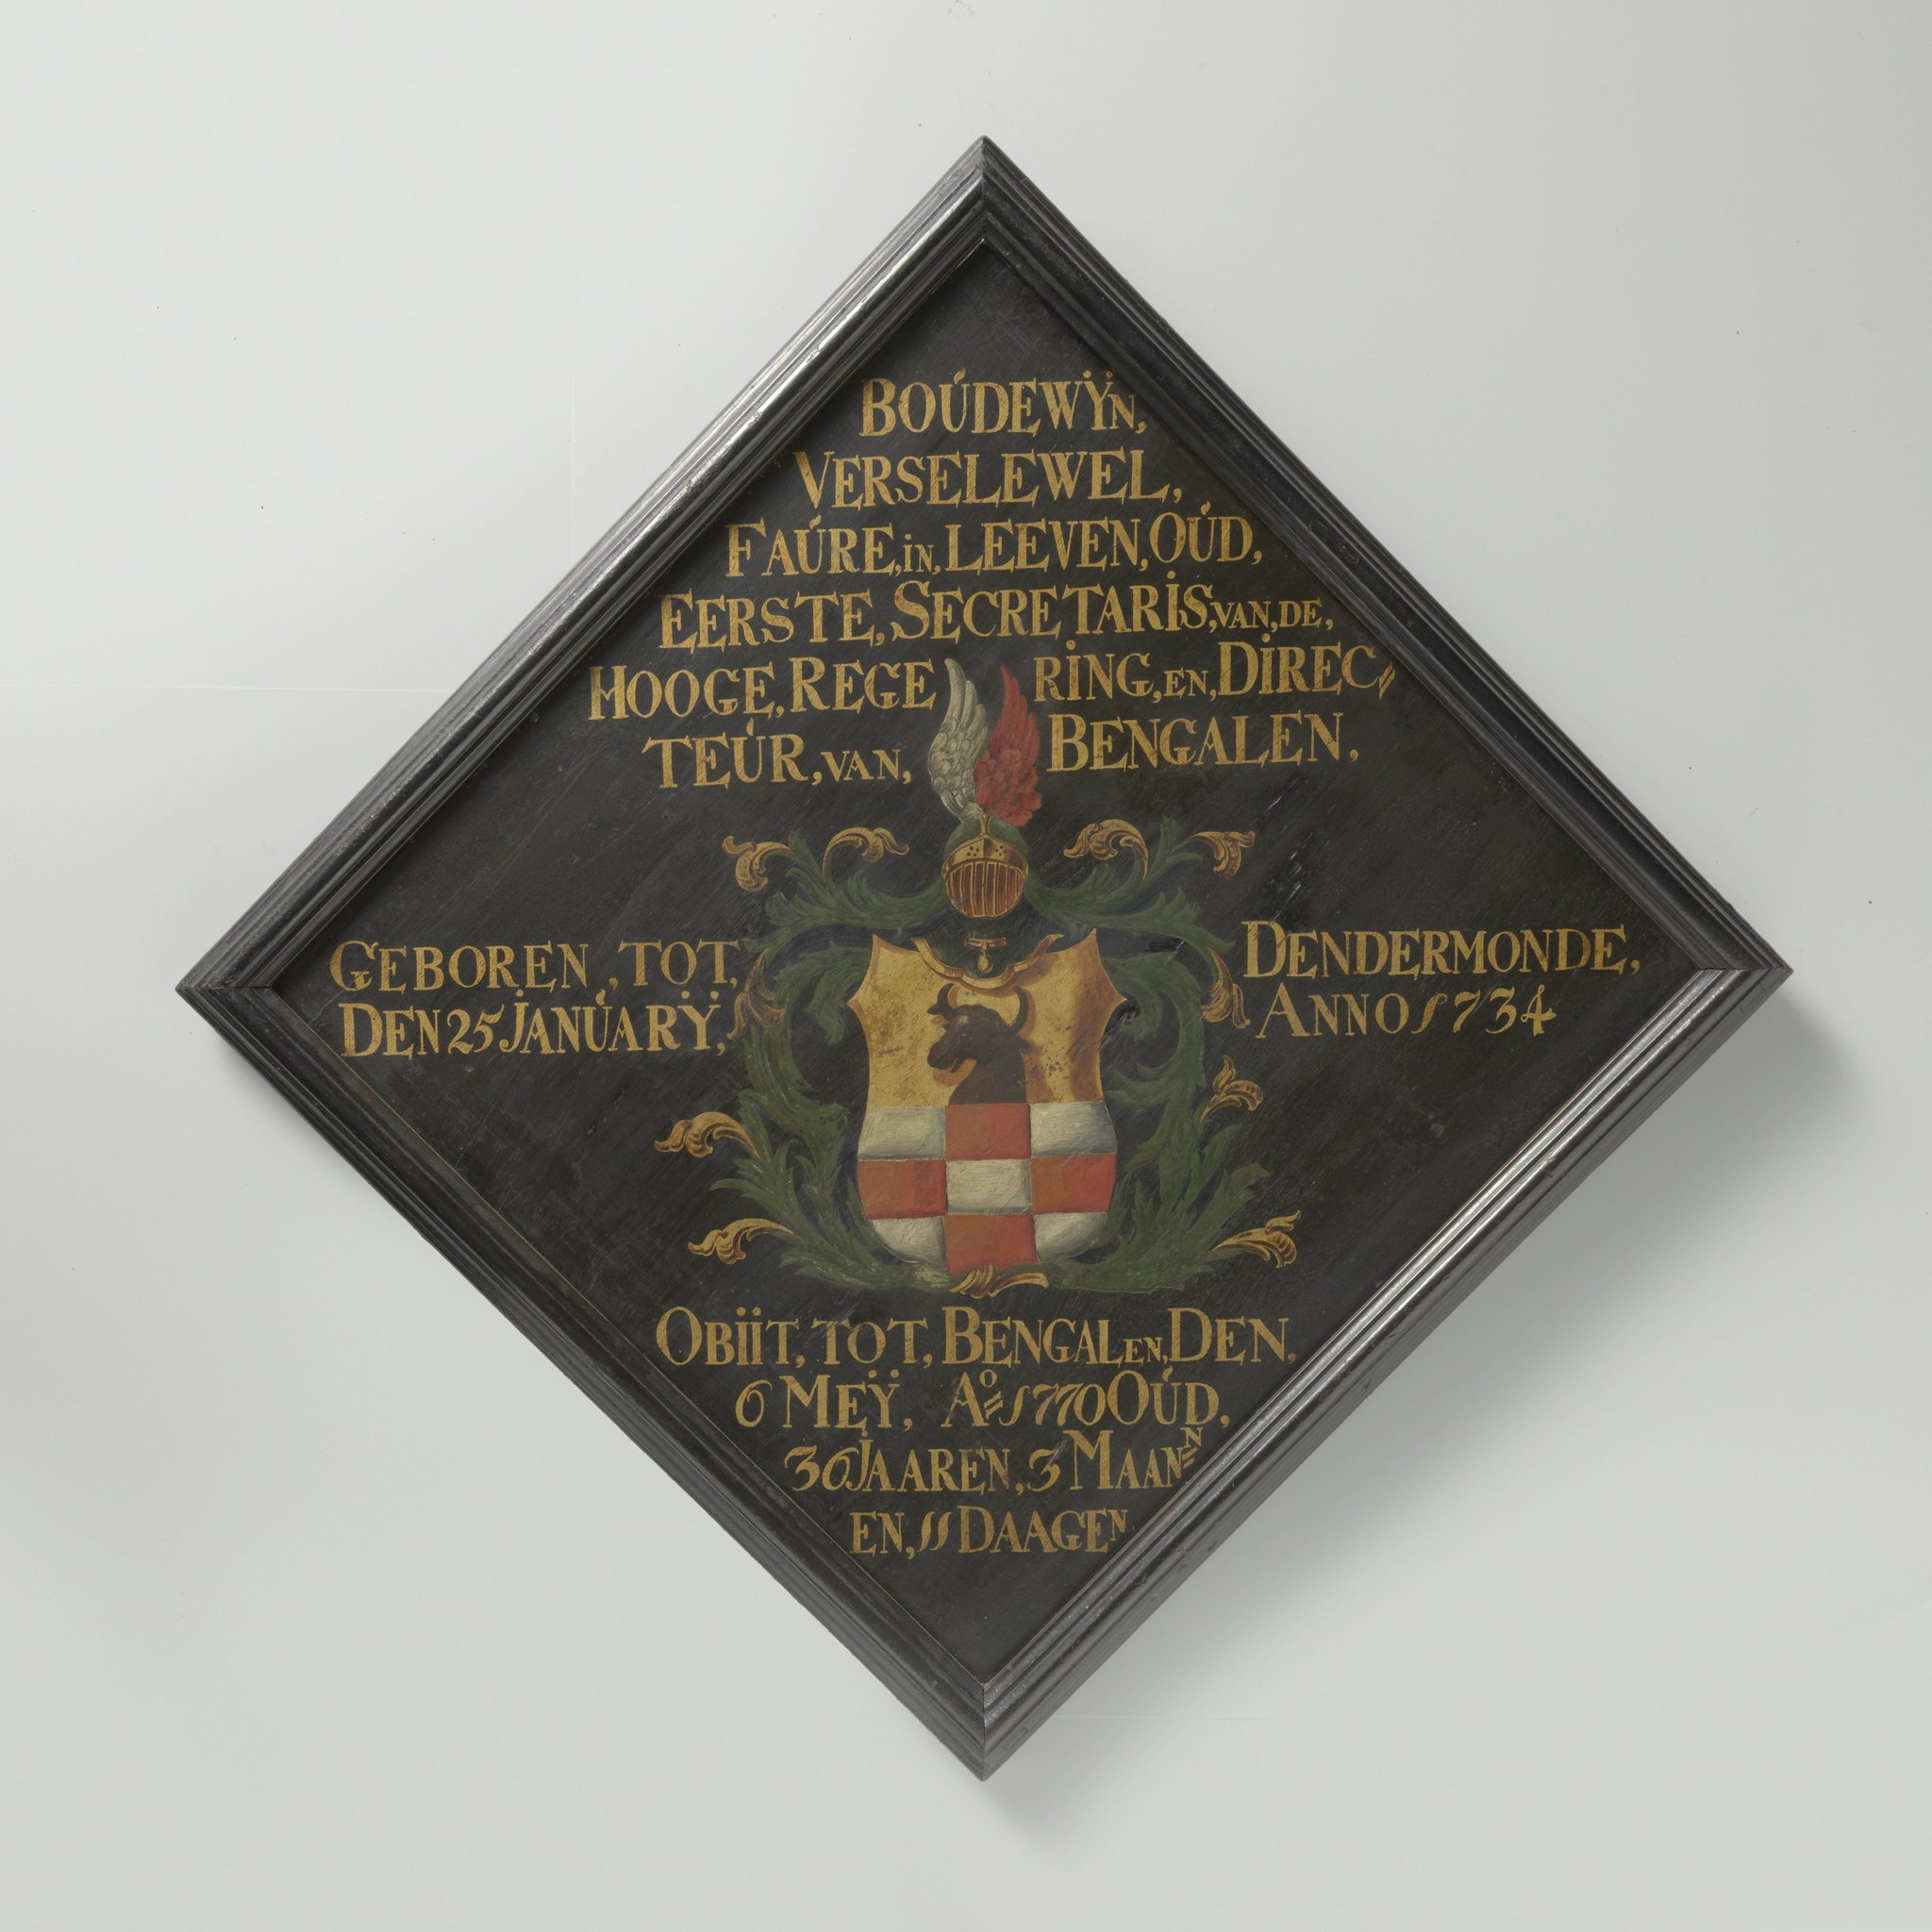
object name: rouwbord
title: Grafbord van Boudewijn Versewel Faure (1734-70), directeur van Bengalen (1769-70)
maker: Anonymous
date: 1770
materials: panel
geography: bengal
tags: armorial bearing, heraldry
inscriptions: : ‘Boúdewijn Versewel Fauré in Leeven Oud Eerste Secretaris van de Hooge Regering en Directeur van Bengalen. Geboren tot Dendermonde Den 25 Januarij Anno 1734. Obiit tot Bengalen Den 6 Meij Ao 1770 Oud 36 Jaaren, 3 Maann= en 11 Daagen’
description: Epitaph from the church in Chinsura, second half 18th century. Chinsura in Bengal (Northeast India) was one of the key trading posts of the VOC. Under its director, George Louis Vernet, a church was built at Chinsura in 1767. As was traditional in European churches, memorials were placed on the walls to commemorate high-ranking officials who had died in Asia in the service of the Company. Far right: Vernet's epitaph - the director died in Batavia in 1775. The second from the left is the epitaph of Theodora Hendrica Piekenbroek. She was the daughter of a Dutch preacher from Batavia. After marrying Boudewijn Versewel Faure - whose memorial is also shown here - she moved to Chinsura, where they both died within a short space of time. Theodora was only 23: the death rate among Europeans in Bengal was high.